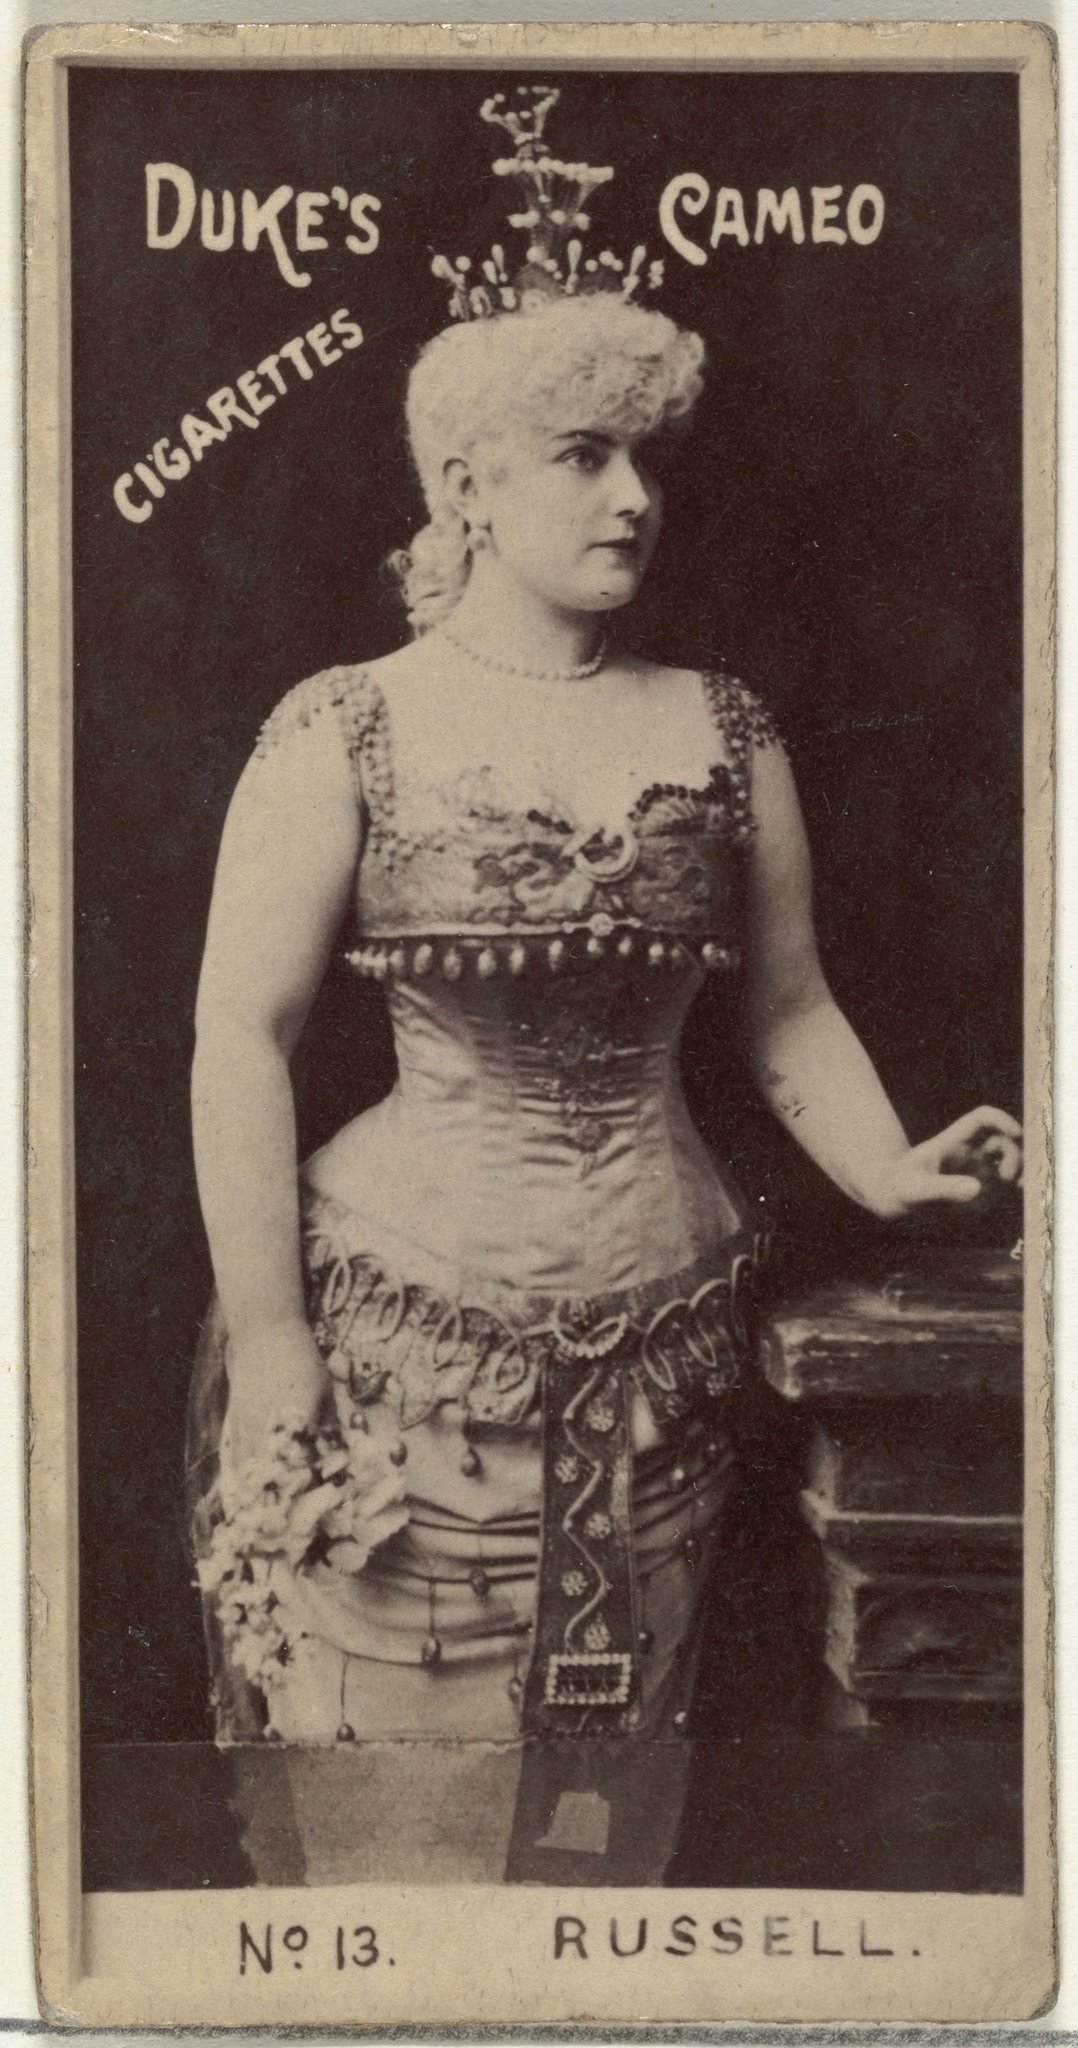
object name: photograph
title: Card Number 13, Lillian Russell, from the Actors and Actresses series (N145-4) issued by Duke Sons & Co. to promote Cameo Cigarettes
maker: w. duke, sons & co.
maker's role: publisher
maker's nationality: american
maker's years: 1870-1920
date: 1880-1889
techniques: albumen silver print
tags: portraits,women,actresses